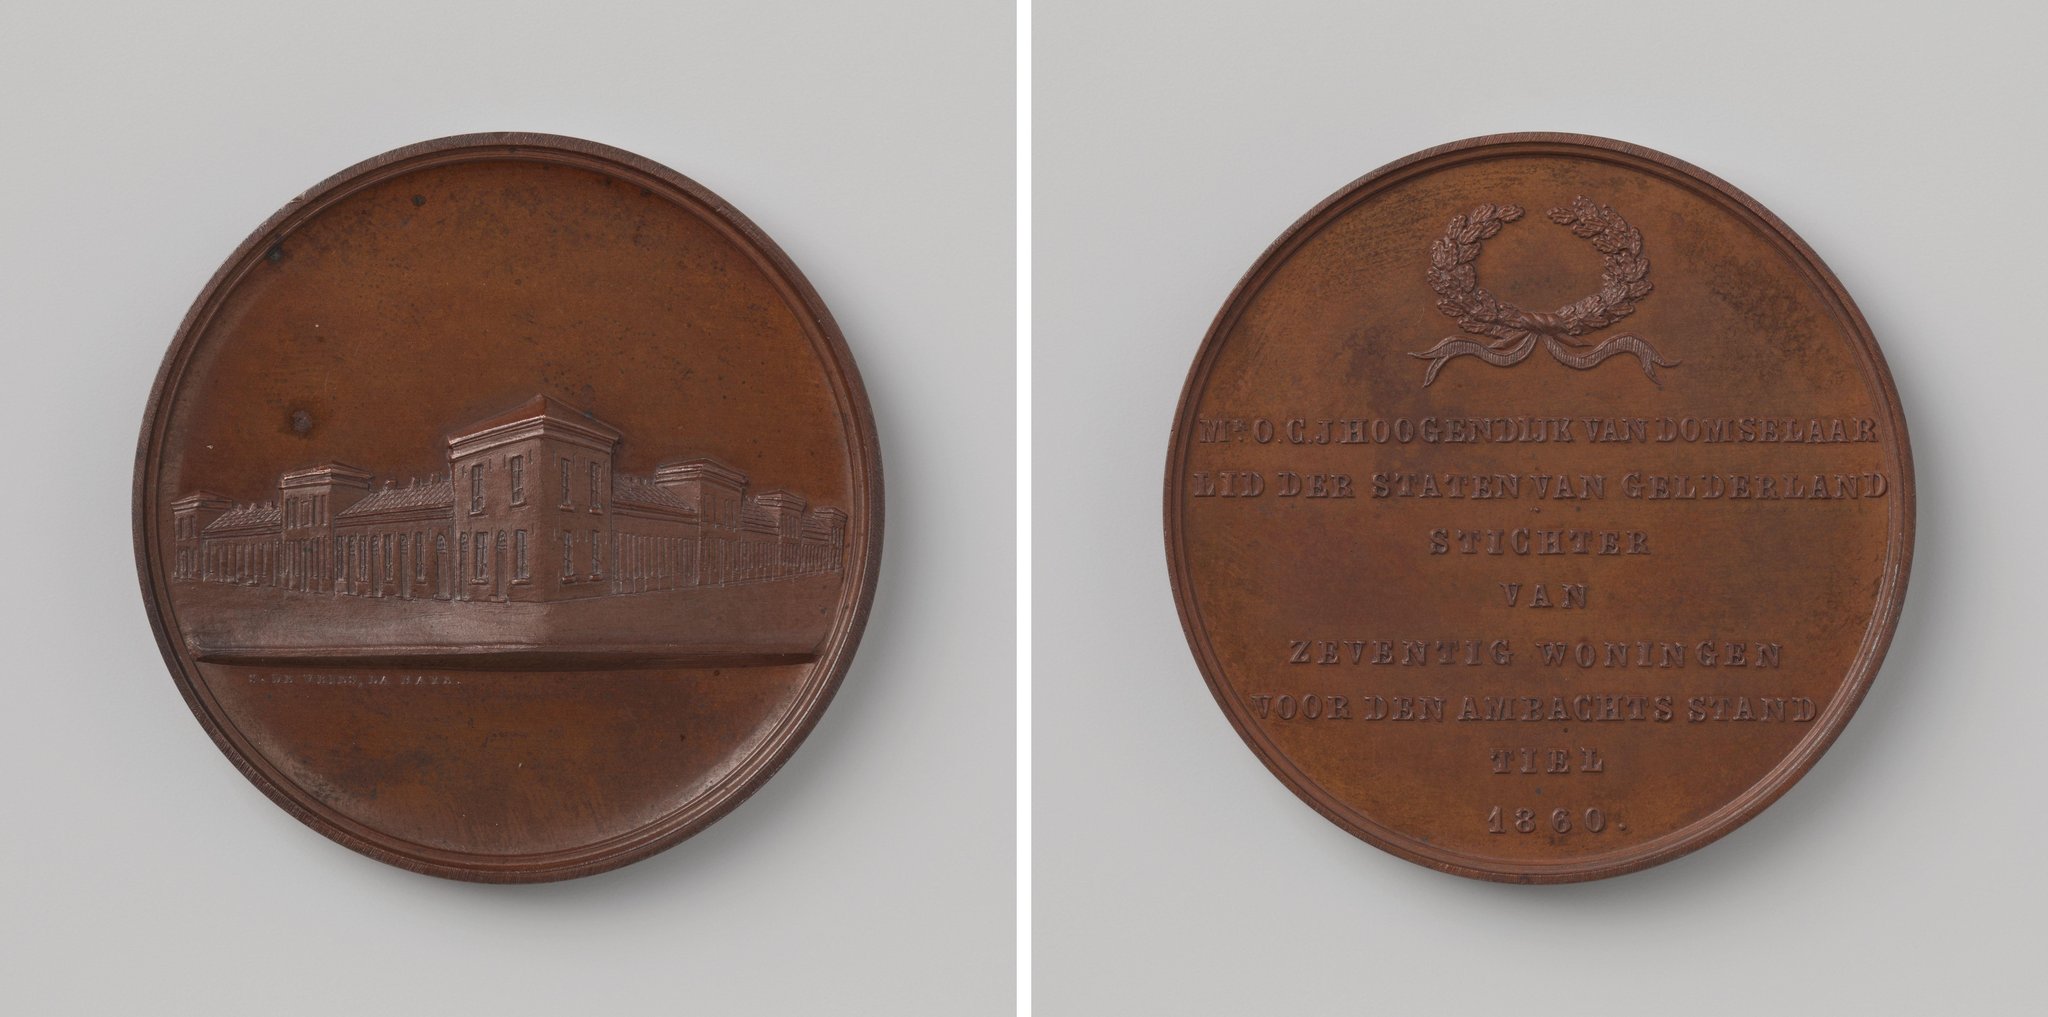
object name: honorary medal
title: O.C.J. Hoogendijk van Domselaar, lid van de Staten van Gelderland, stichter van zeventig huizen voor ambachtslieden te Tiel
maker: salomon de vries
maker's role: graveur, medailleur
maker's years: 1830-1899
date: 1860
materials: bronze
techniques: striking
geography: the hague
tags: o.c.j. hoogendijk van domselaar, staten van gelderland, tiel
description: Bronzen penning. Voorzijde: huizenblok; afsnede: signatuur. Keerzijde: opschrift onder eikekrans met linten